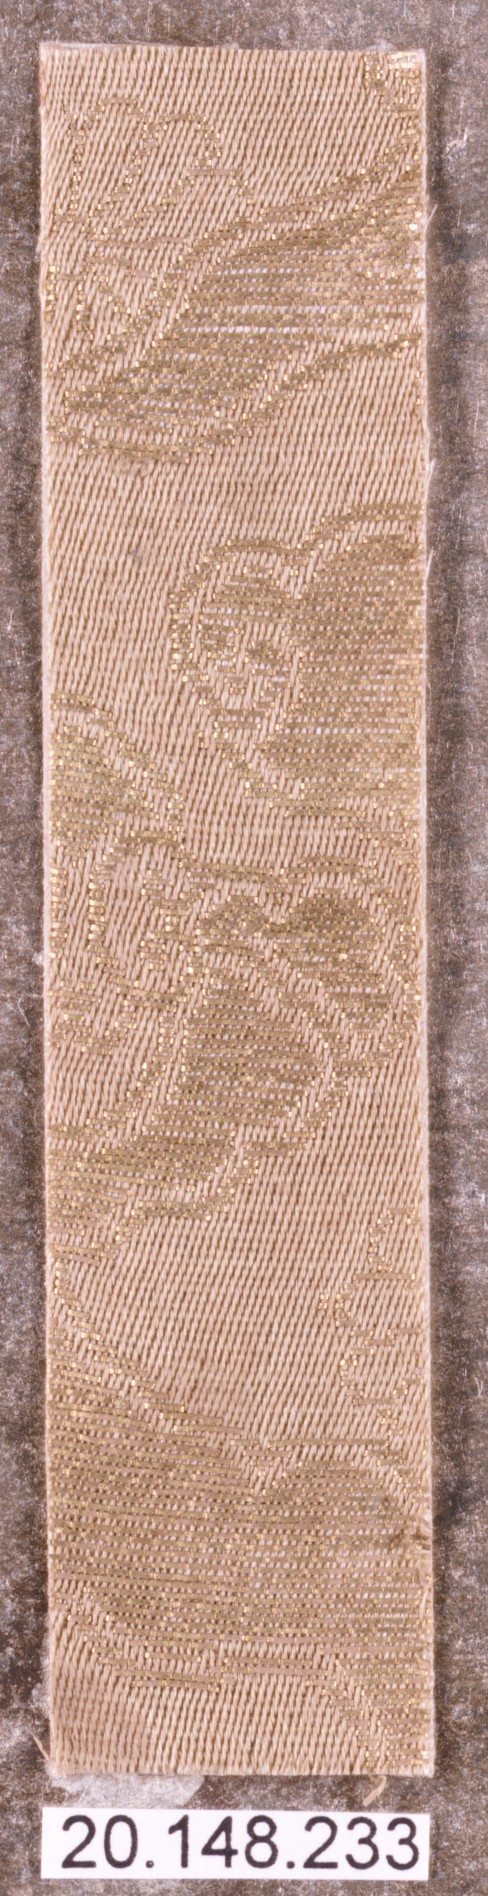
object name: piece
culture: japanese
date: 1601-1700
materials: silk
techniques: compound weave